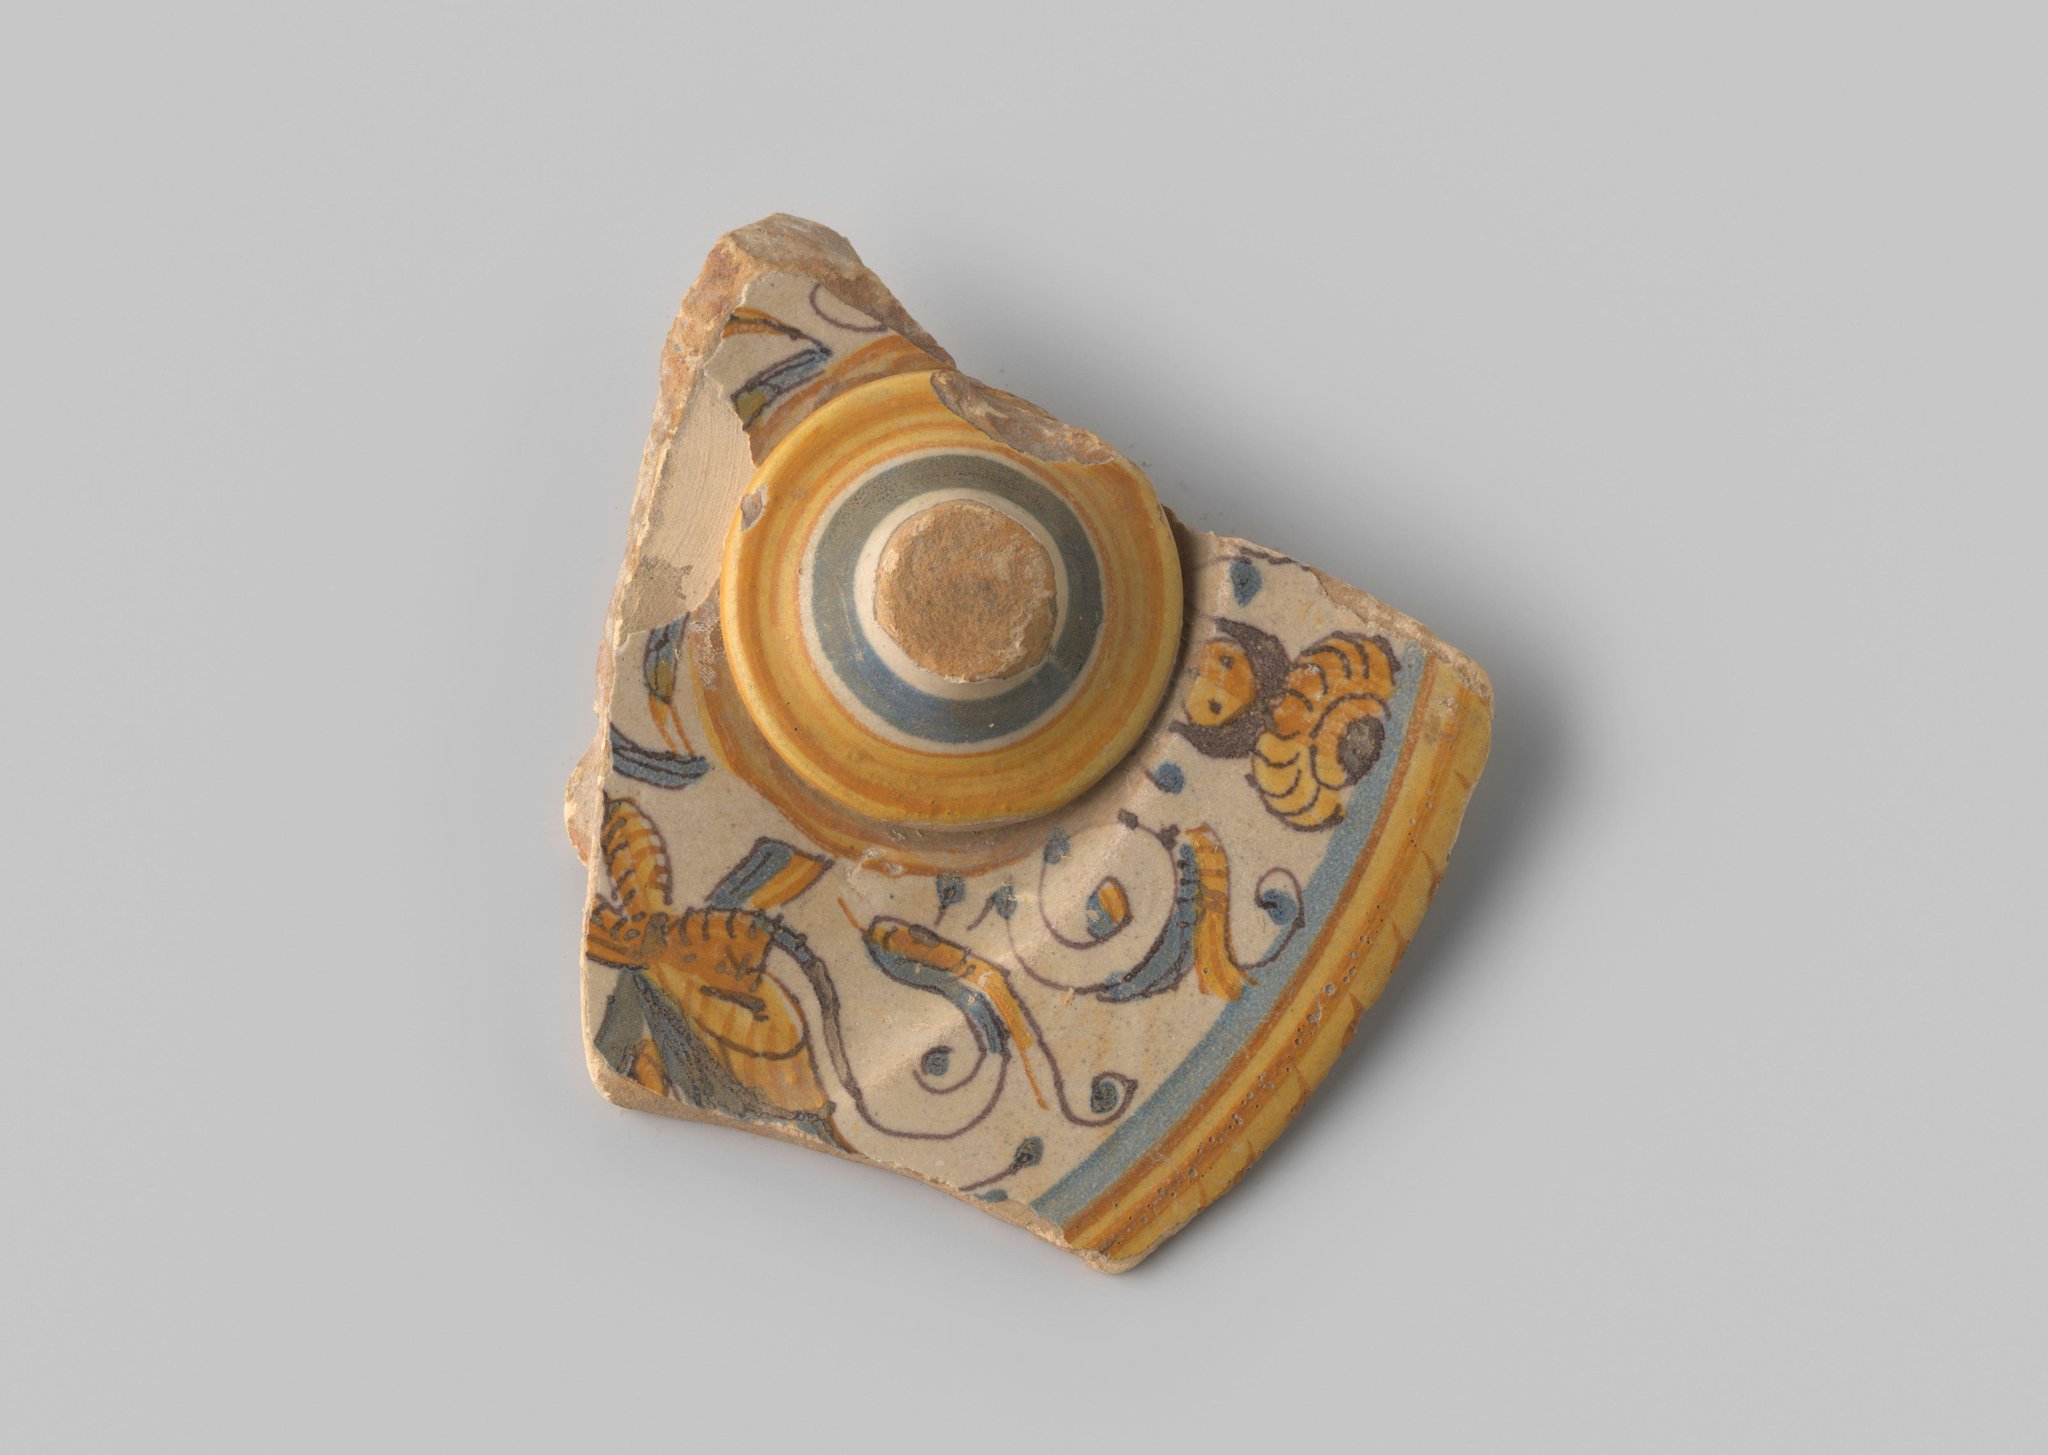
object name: sherd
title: Fragment met rossige scherf, aan de bovenzijde voorzien van een voet van een afgebroken onderdeel van het voorwerp, en een decoratie van florale vormen in blauw, geel, oranje en bruin op een witte ondergrond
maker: Anonymous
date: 1200-1899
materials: earthenware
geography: italy